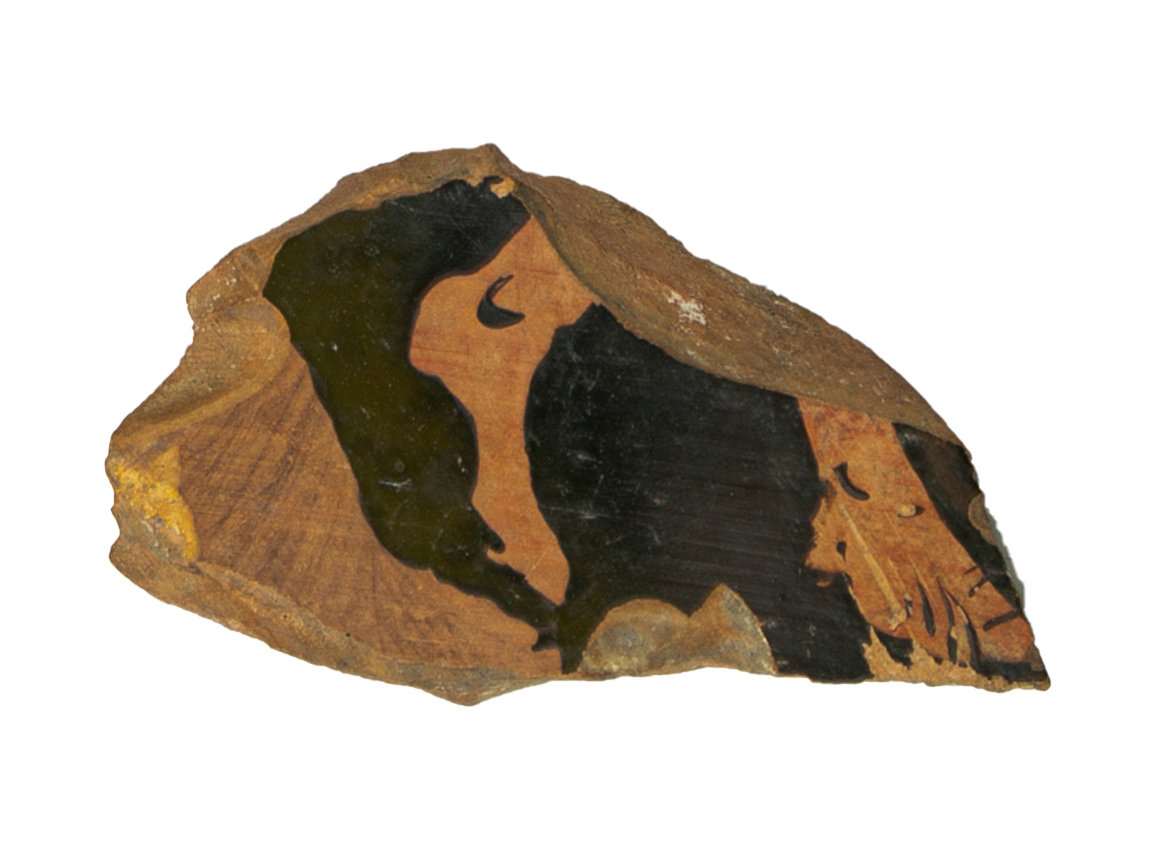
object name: volute krater fragment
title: Volute-krater fragment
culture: greek, south italian, apulian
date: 360-340 BCE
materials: terracotta